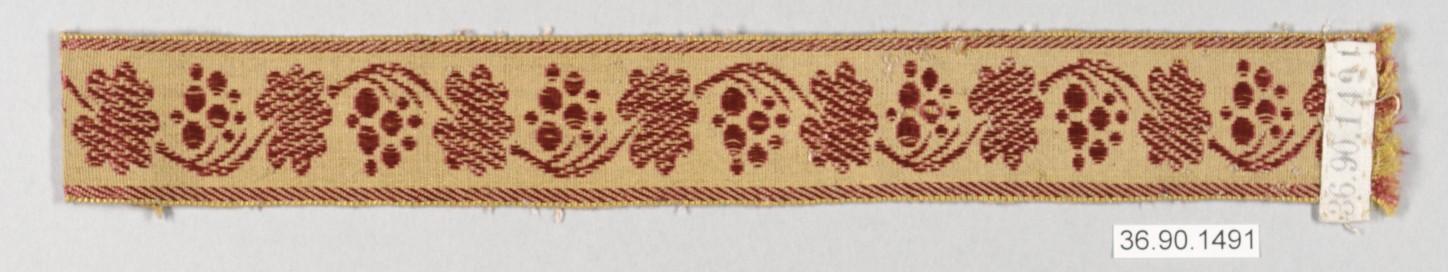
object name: ribbon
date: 1801-1900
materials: silk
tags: flowers